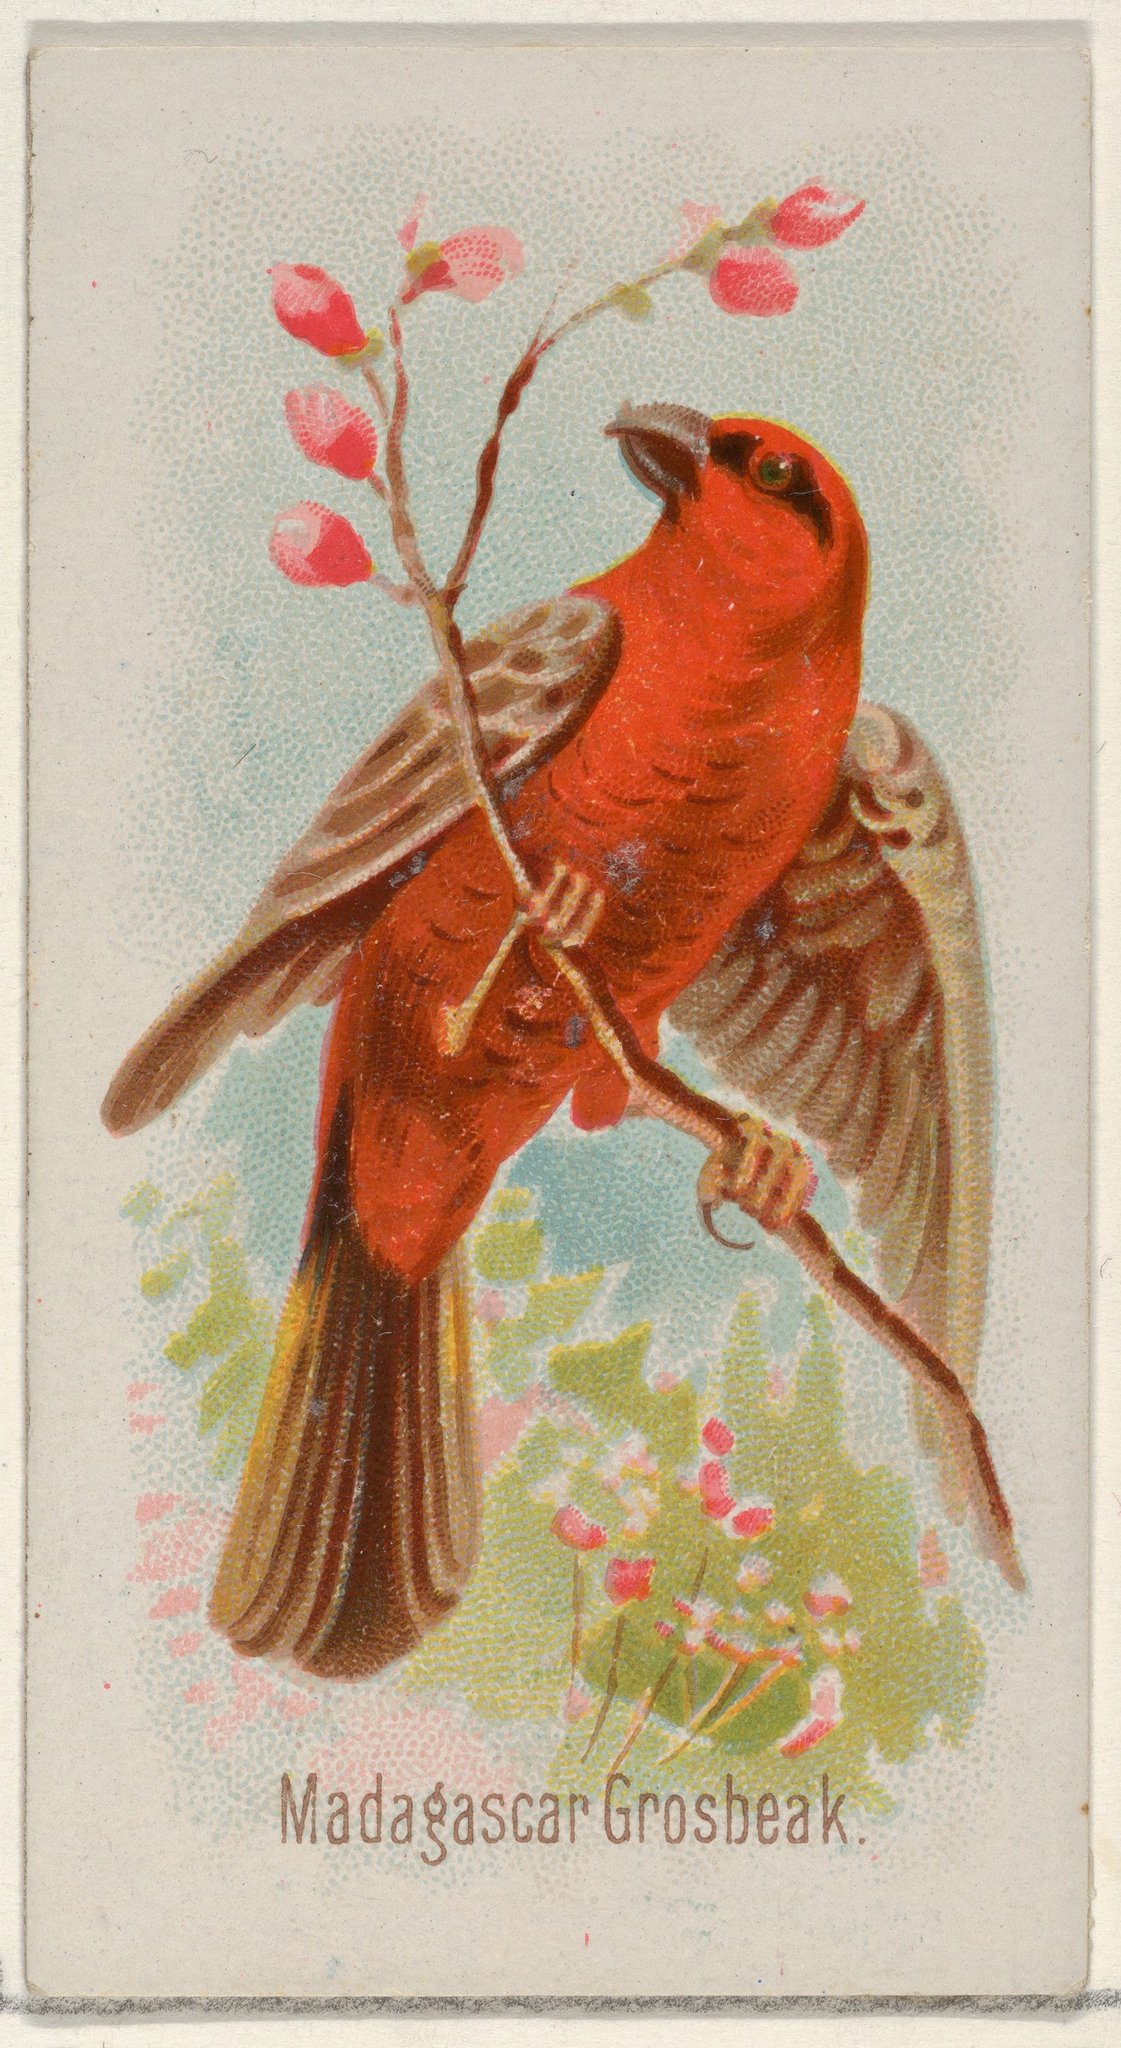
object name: print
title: Madagascar Grosbeak, from the Song Birds of the World series (N23) for Allen & Ginter Cigarettes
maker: allen & ginter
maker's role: publisher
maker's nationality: american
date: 1890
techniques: color lithograph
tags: birds